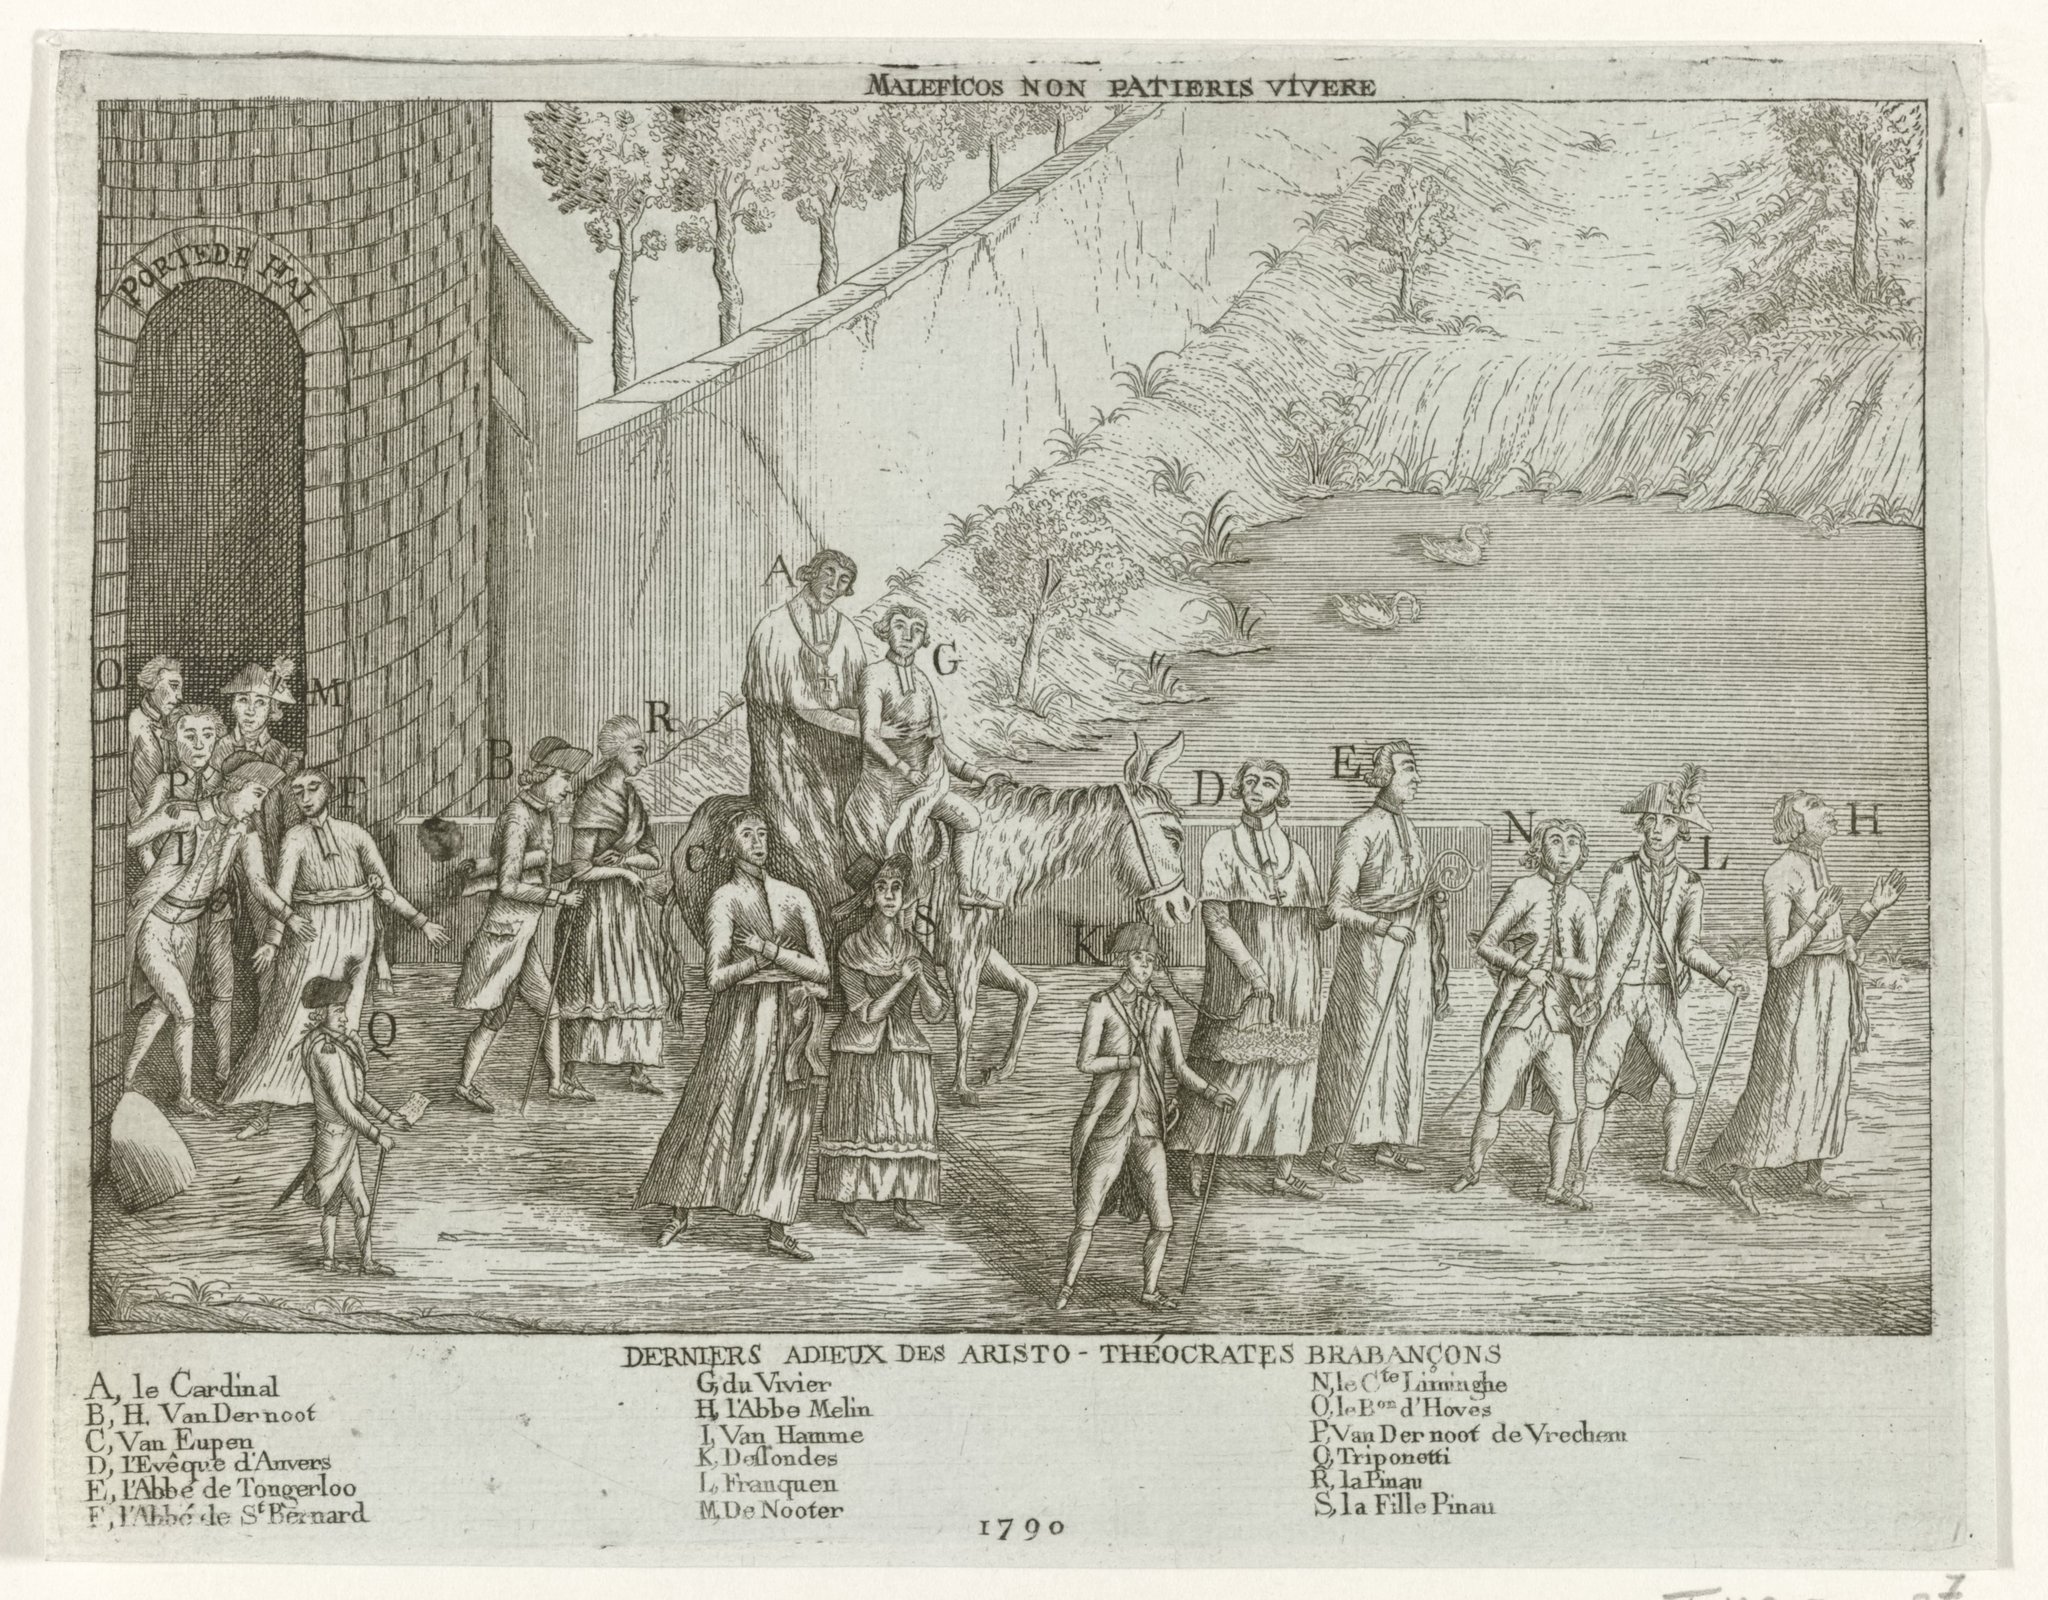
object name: cartoon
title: Maleficos non patieris vivere / Derniers adieux des Aristo-Theocrates Brabançons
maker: Anonymous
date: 1790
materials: paper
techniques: engraving, etching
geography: southern netherlands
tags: brussels, politician, exile (of old government or its adherents)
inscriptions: collector's mark: Lugt 2228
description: De Brabantse theocraten worden door de Hallepoort uit Brussel verdreven. Met legenda A-S met de namen van de voorgestelden. Onderdeel van een grote groep van prenten betrekking hebbend op de gebeurtenissen van de Brabantse Omwenteling en de periode 1787-1790.